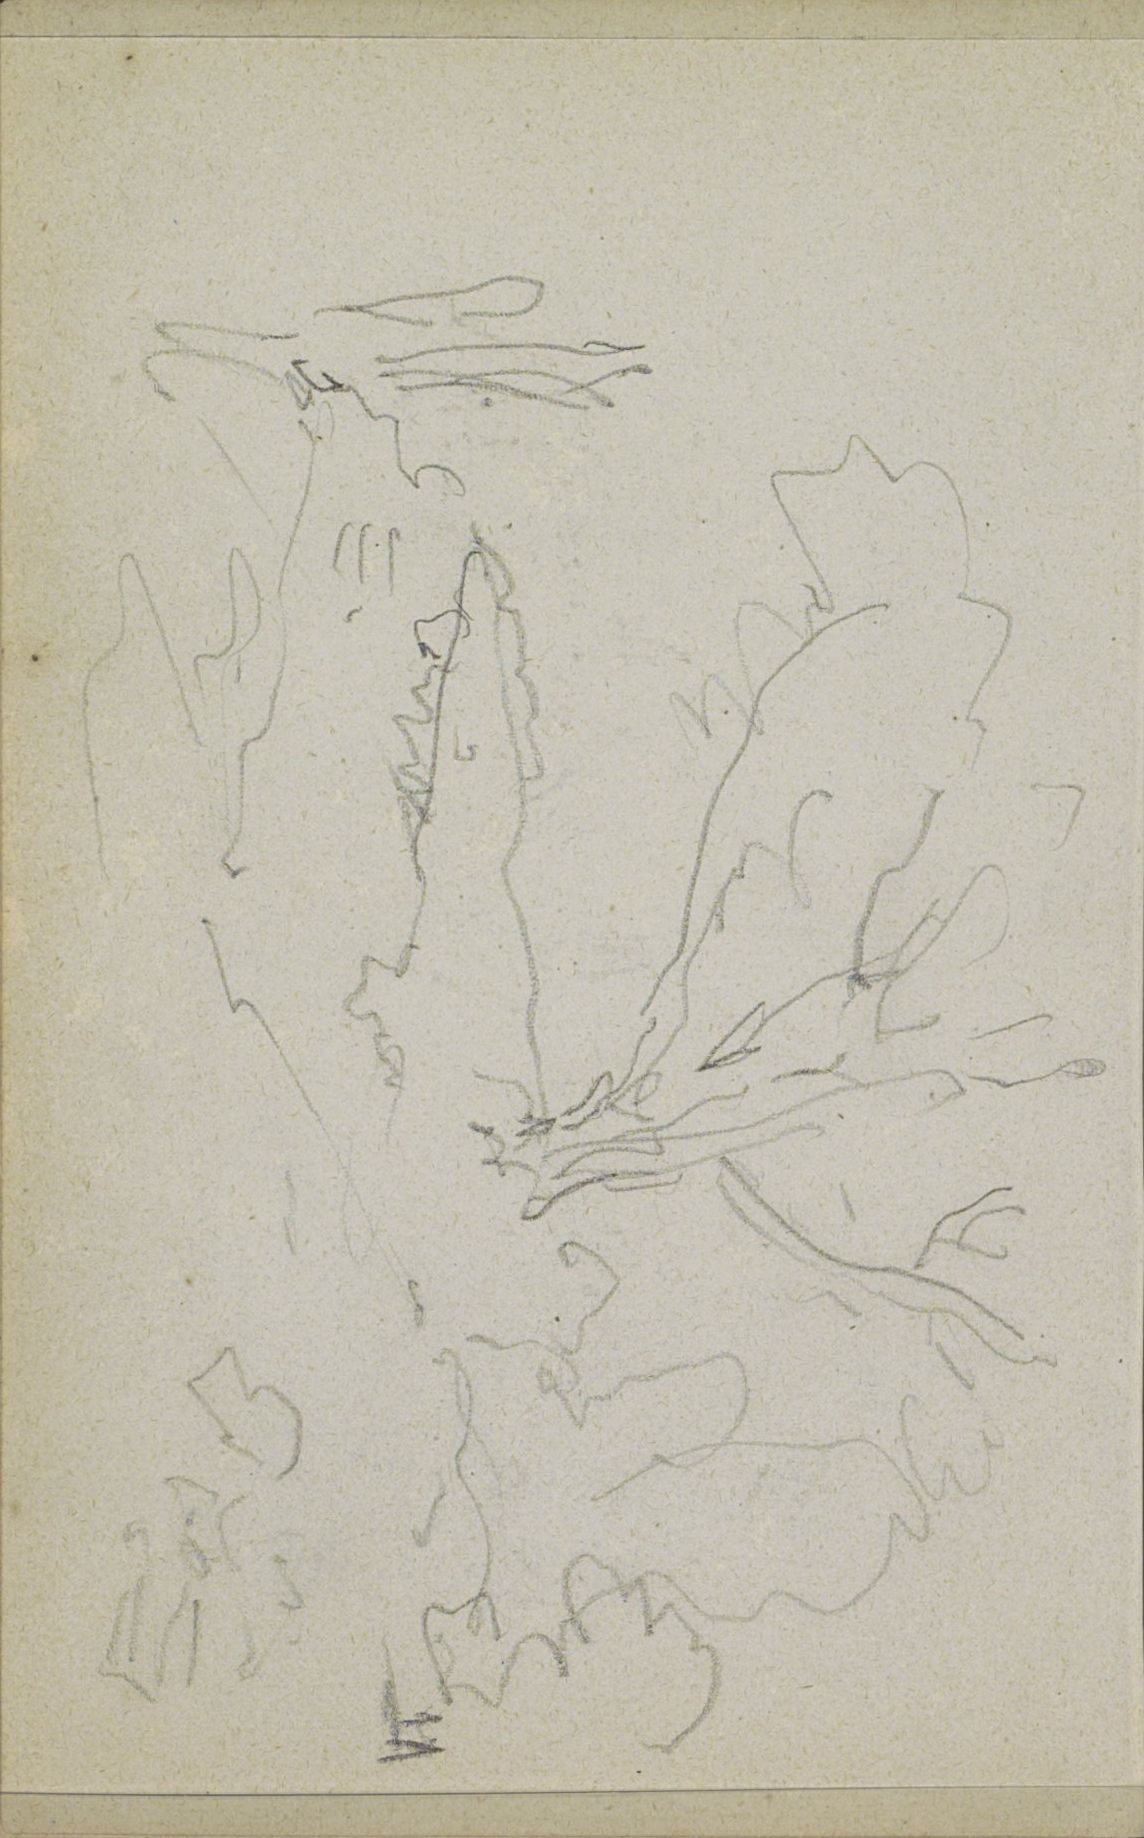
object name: sketchbook leaf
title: Landschap met een boom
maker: adrianus eversen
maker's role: draughtsman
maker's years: 1818-1897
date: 1828-1897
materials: paper, pencil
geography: netherlands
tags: trees, landscapes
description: Landschap met in het midden een boom. Links mogelijk water. Blad 32 verso uit een schetsboek met 58 bladen.